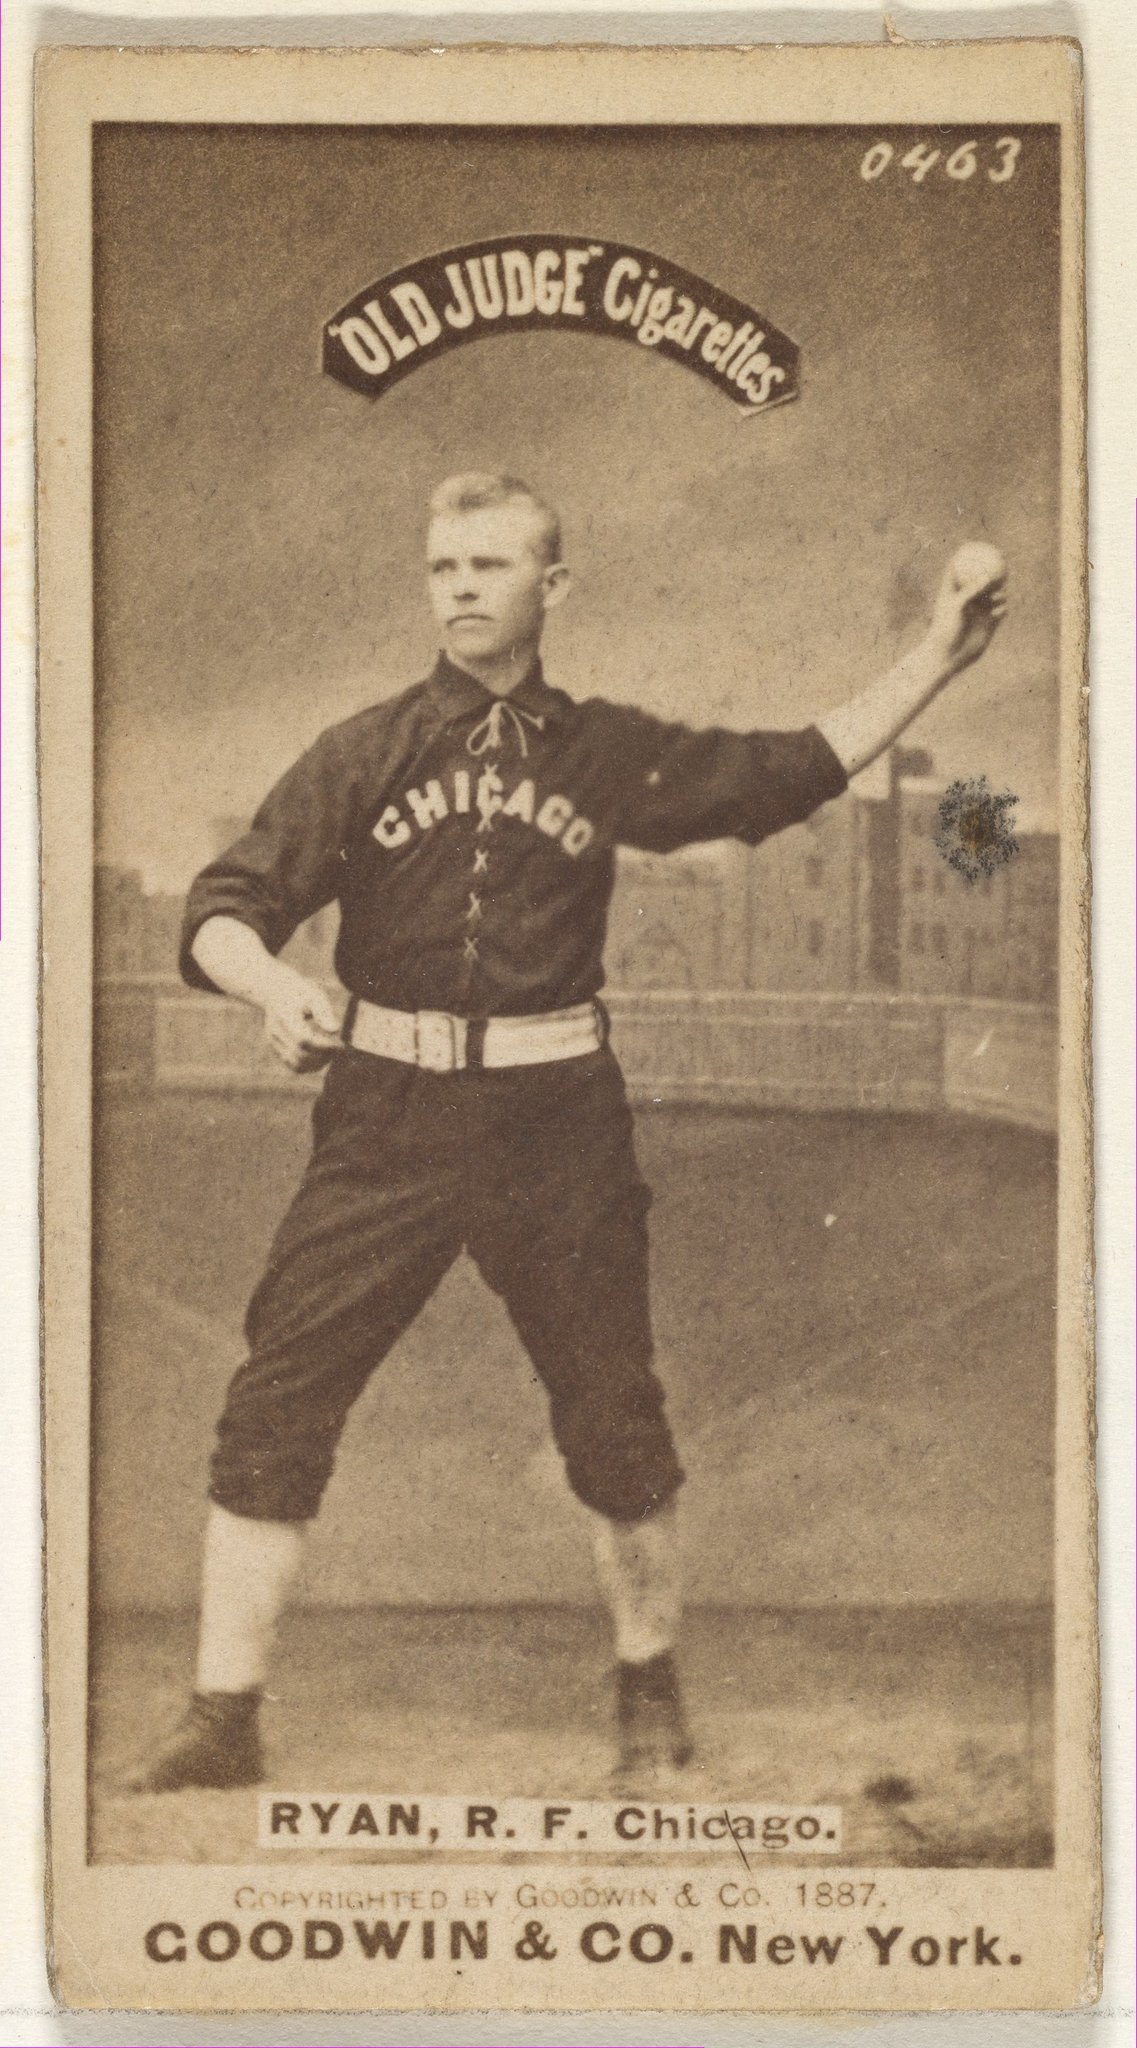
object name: baseball card, photograph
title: Ryan, Right Field, Chicago, from the Old Judge series (N172) for Old Judge Cigarettes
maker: goodwin & company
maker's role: publisher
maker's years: 1850-1950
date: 1887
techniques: albumen silver print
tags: men,portraits,baseball,athletes